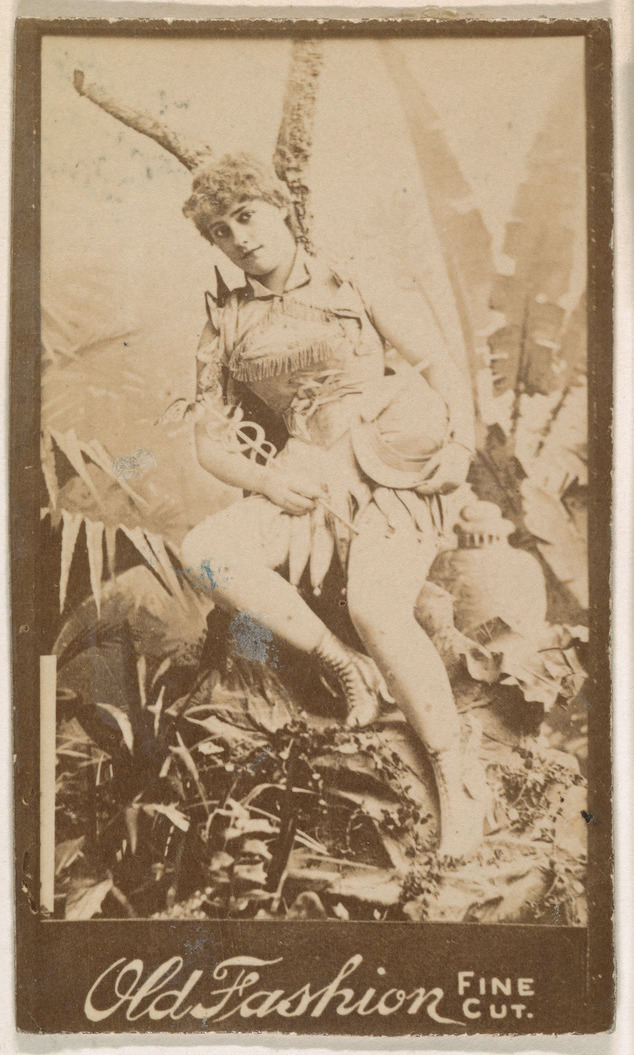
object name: photograph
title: Actress leaning against prop tree, from the Actresses series (N664) promoting Old Fashion Fine Cut Tobacco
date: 1888-1890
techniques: albumen silver print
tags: portraits,women,actresses